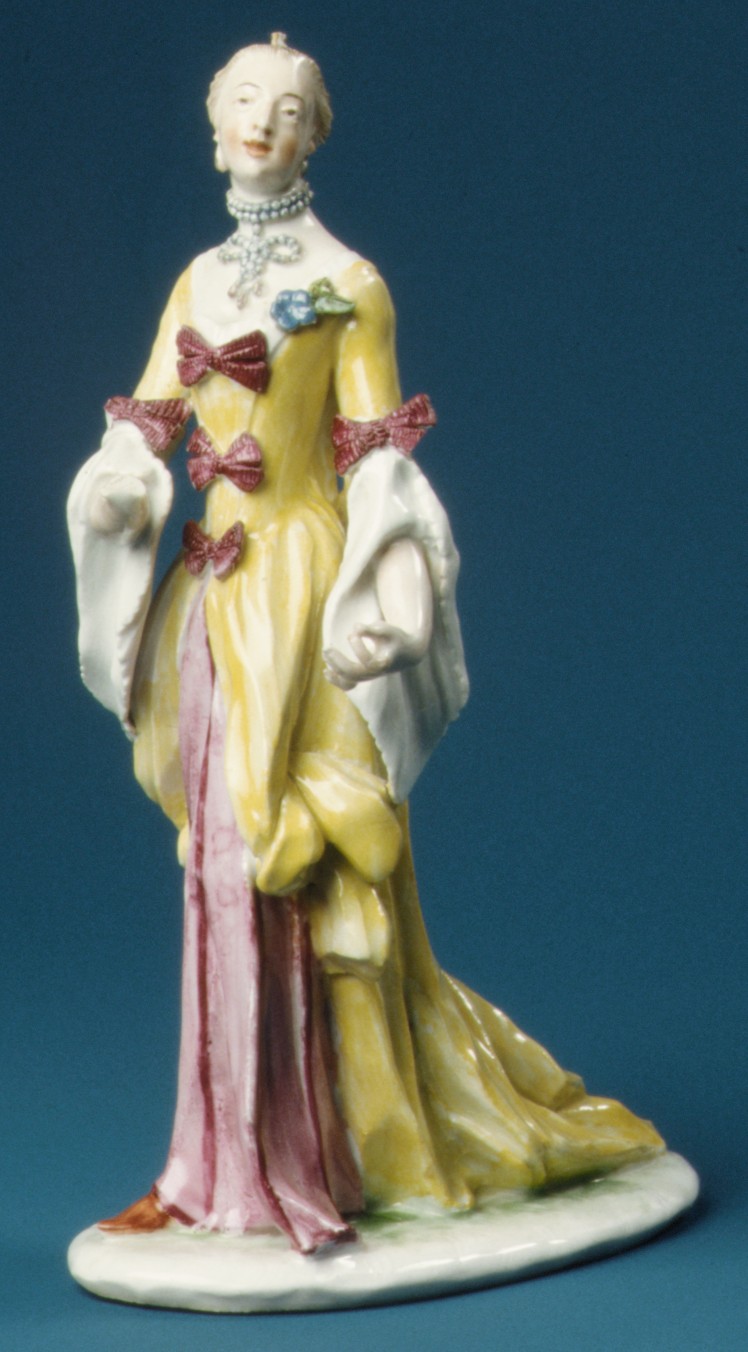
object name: figure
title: Standing woman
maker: nymphenburg porcelain manufactory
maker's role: manufactory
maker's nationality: german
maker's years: 1747-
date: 1750-1755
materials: hard paste porcelain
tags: women